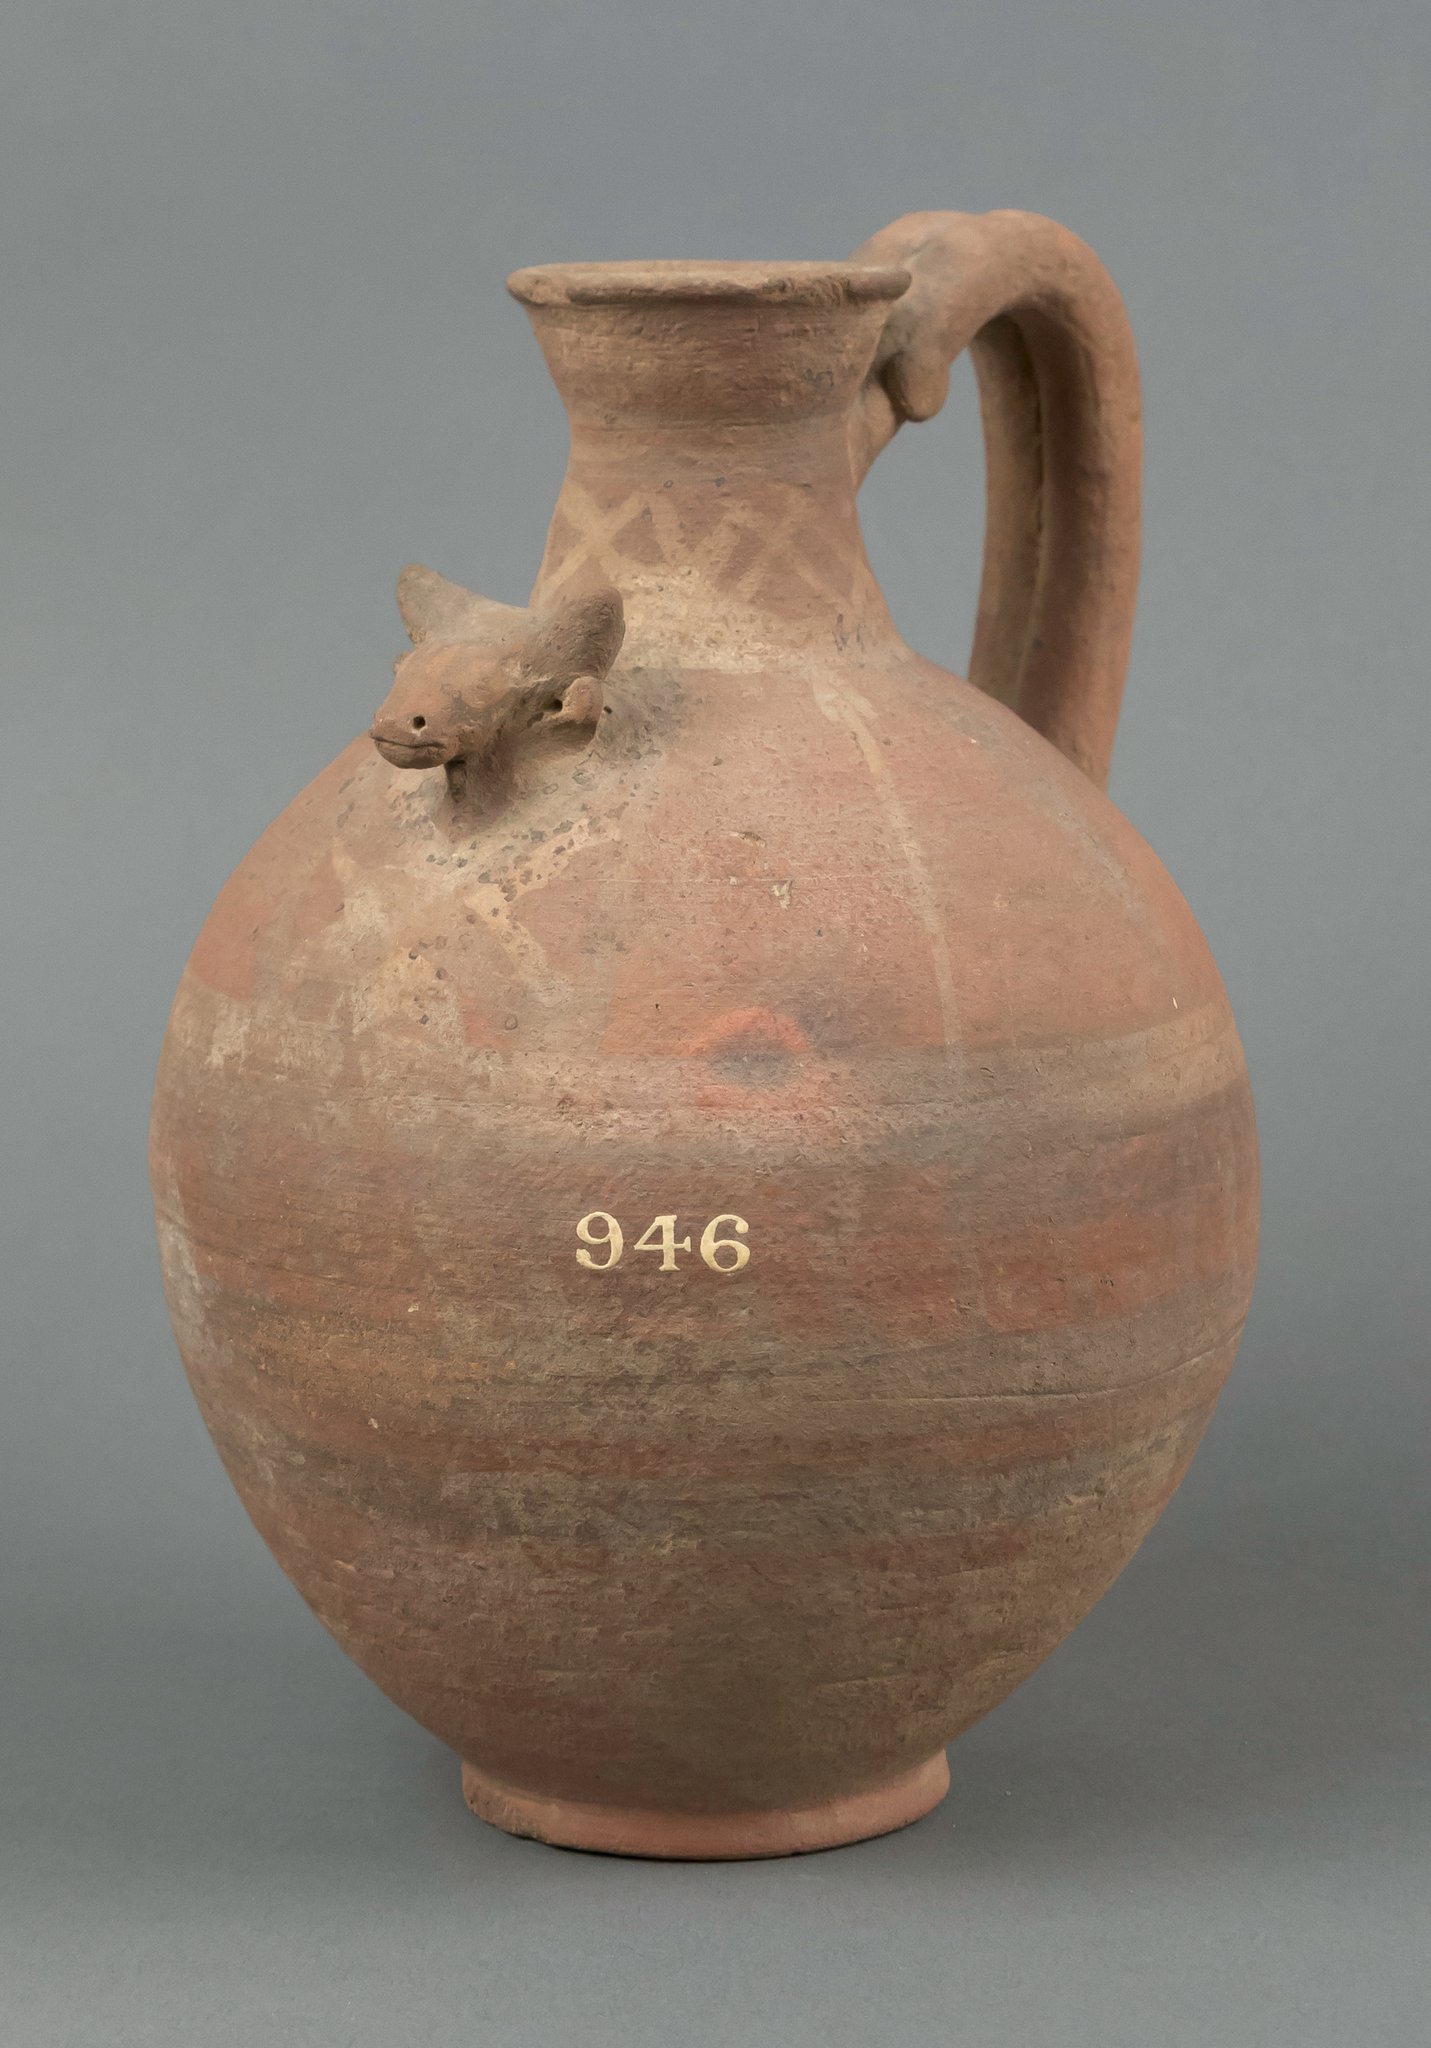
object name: jug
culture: cypriot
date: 600-480 BCE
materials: terracotta